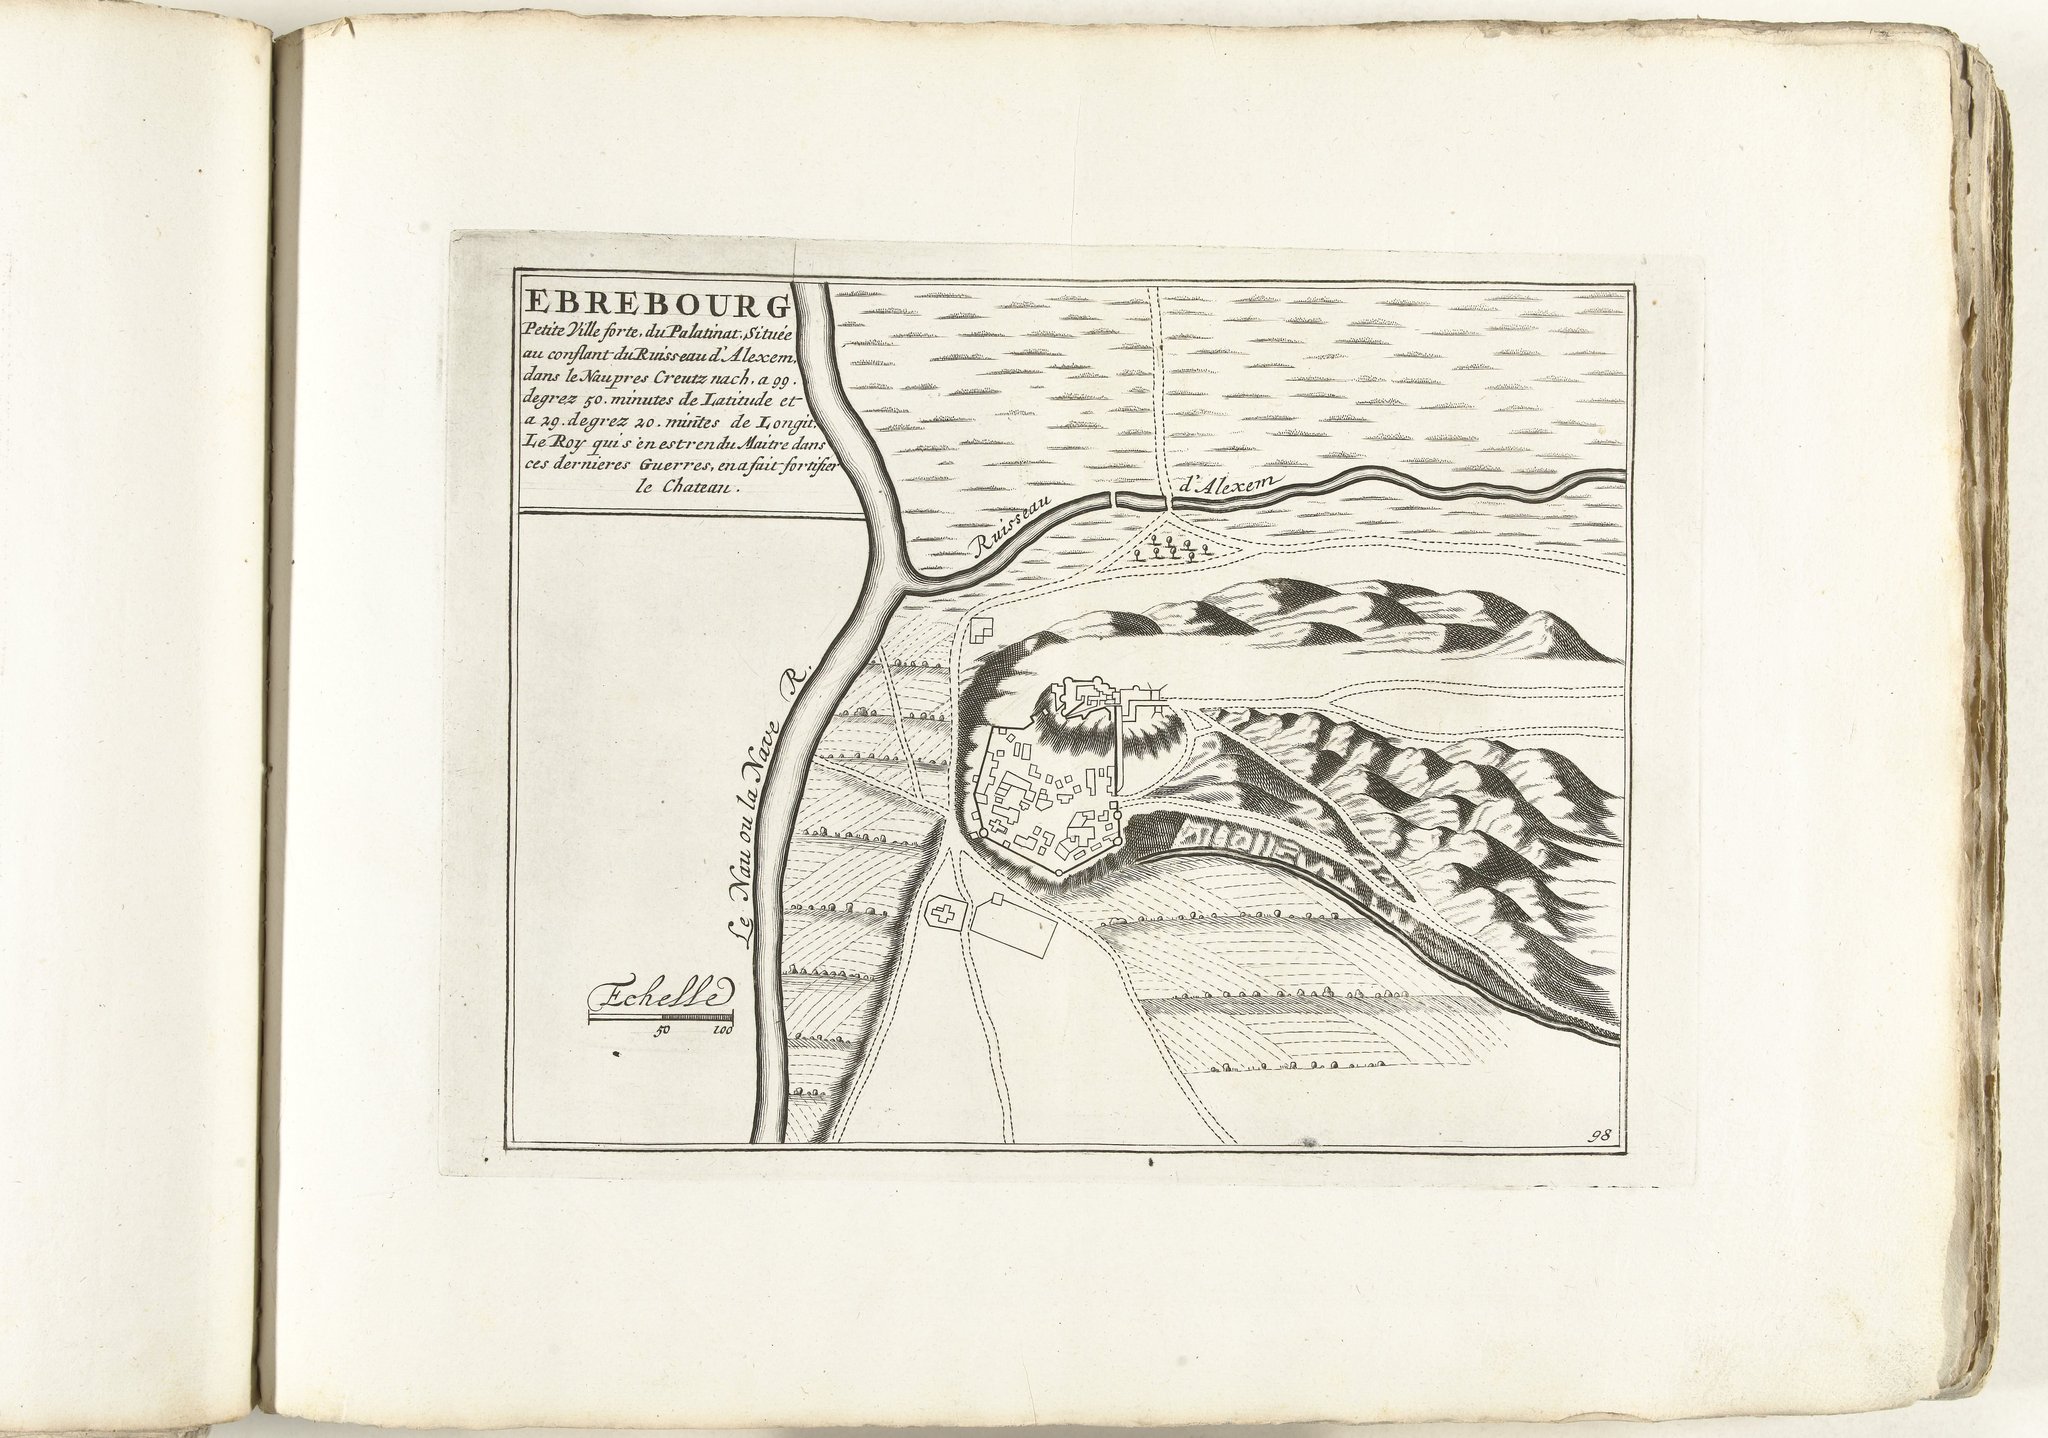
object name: map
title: Plattegrond van Ebrébourg, ca. 1702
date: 1702-1703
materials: paper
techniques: engraving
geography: amsterdam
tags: fortress, maps of cities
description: Plattegrond van de versterkingen om het plaatsje Ebrébourg in Rheinland-Pfalz. Plaat nr. 98 in het prentwerk bestaande in totaal uit 276 genummerde platen van vermaarde sterke steden en vestingen in het kader van de Spaanse Successieoorlog. Voor het merendeel zijn deze platen gekopieerd naar de anonieme Franse platen: in Les forces de l'Europe en in: Le theatre de la guerre, dans les Pays-Bas, beide oorspronkelijk uitgegeven door Nicolas de Fer te Parijs (1693-1697) in het kader van de Negenjarige Oorlog. Titel en opschriften in de plaat in het Frans.